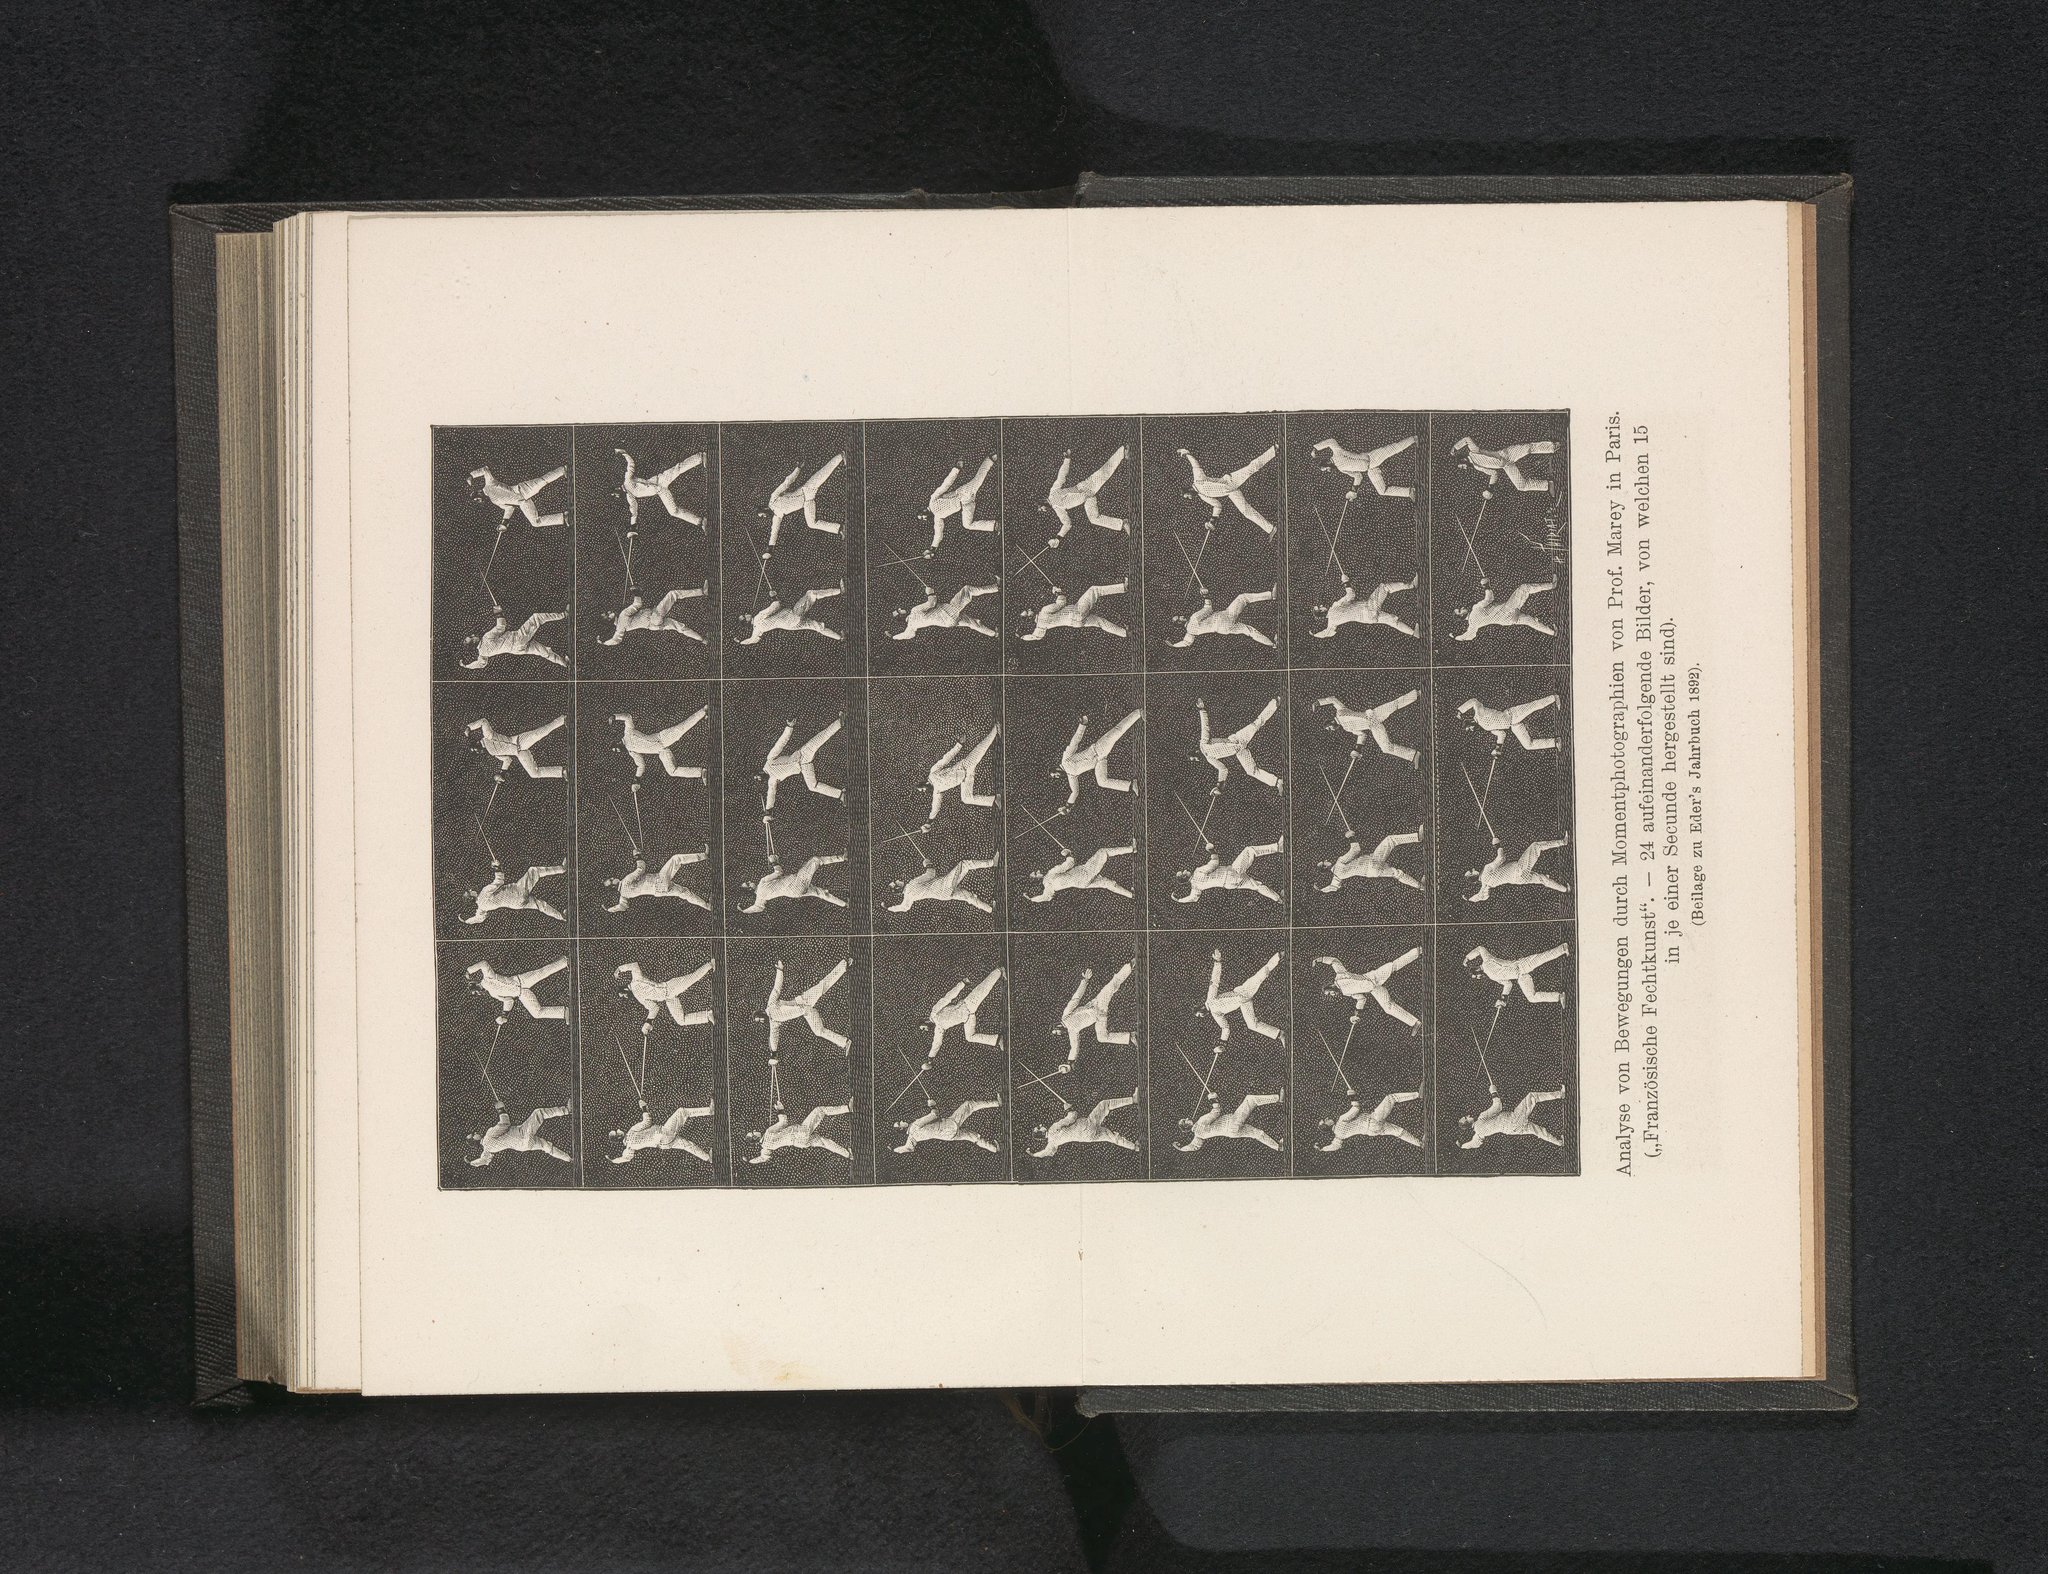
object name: photomechanical print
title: Vierentwintig voorbeelden van schermende mensen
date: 1887-1892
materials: paper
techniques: printing block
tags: fencing (sport)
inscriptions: inscription: ‘Analyse von Bewegungen durch Momentphotographien von Prof. Marey in Paris (...)’